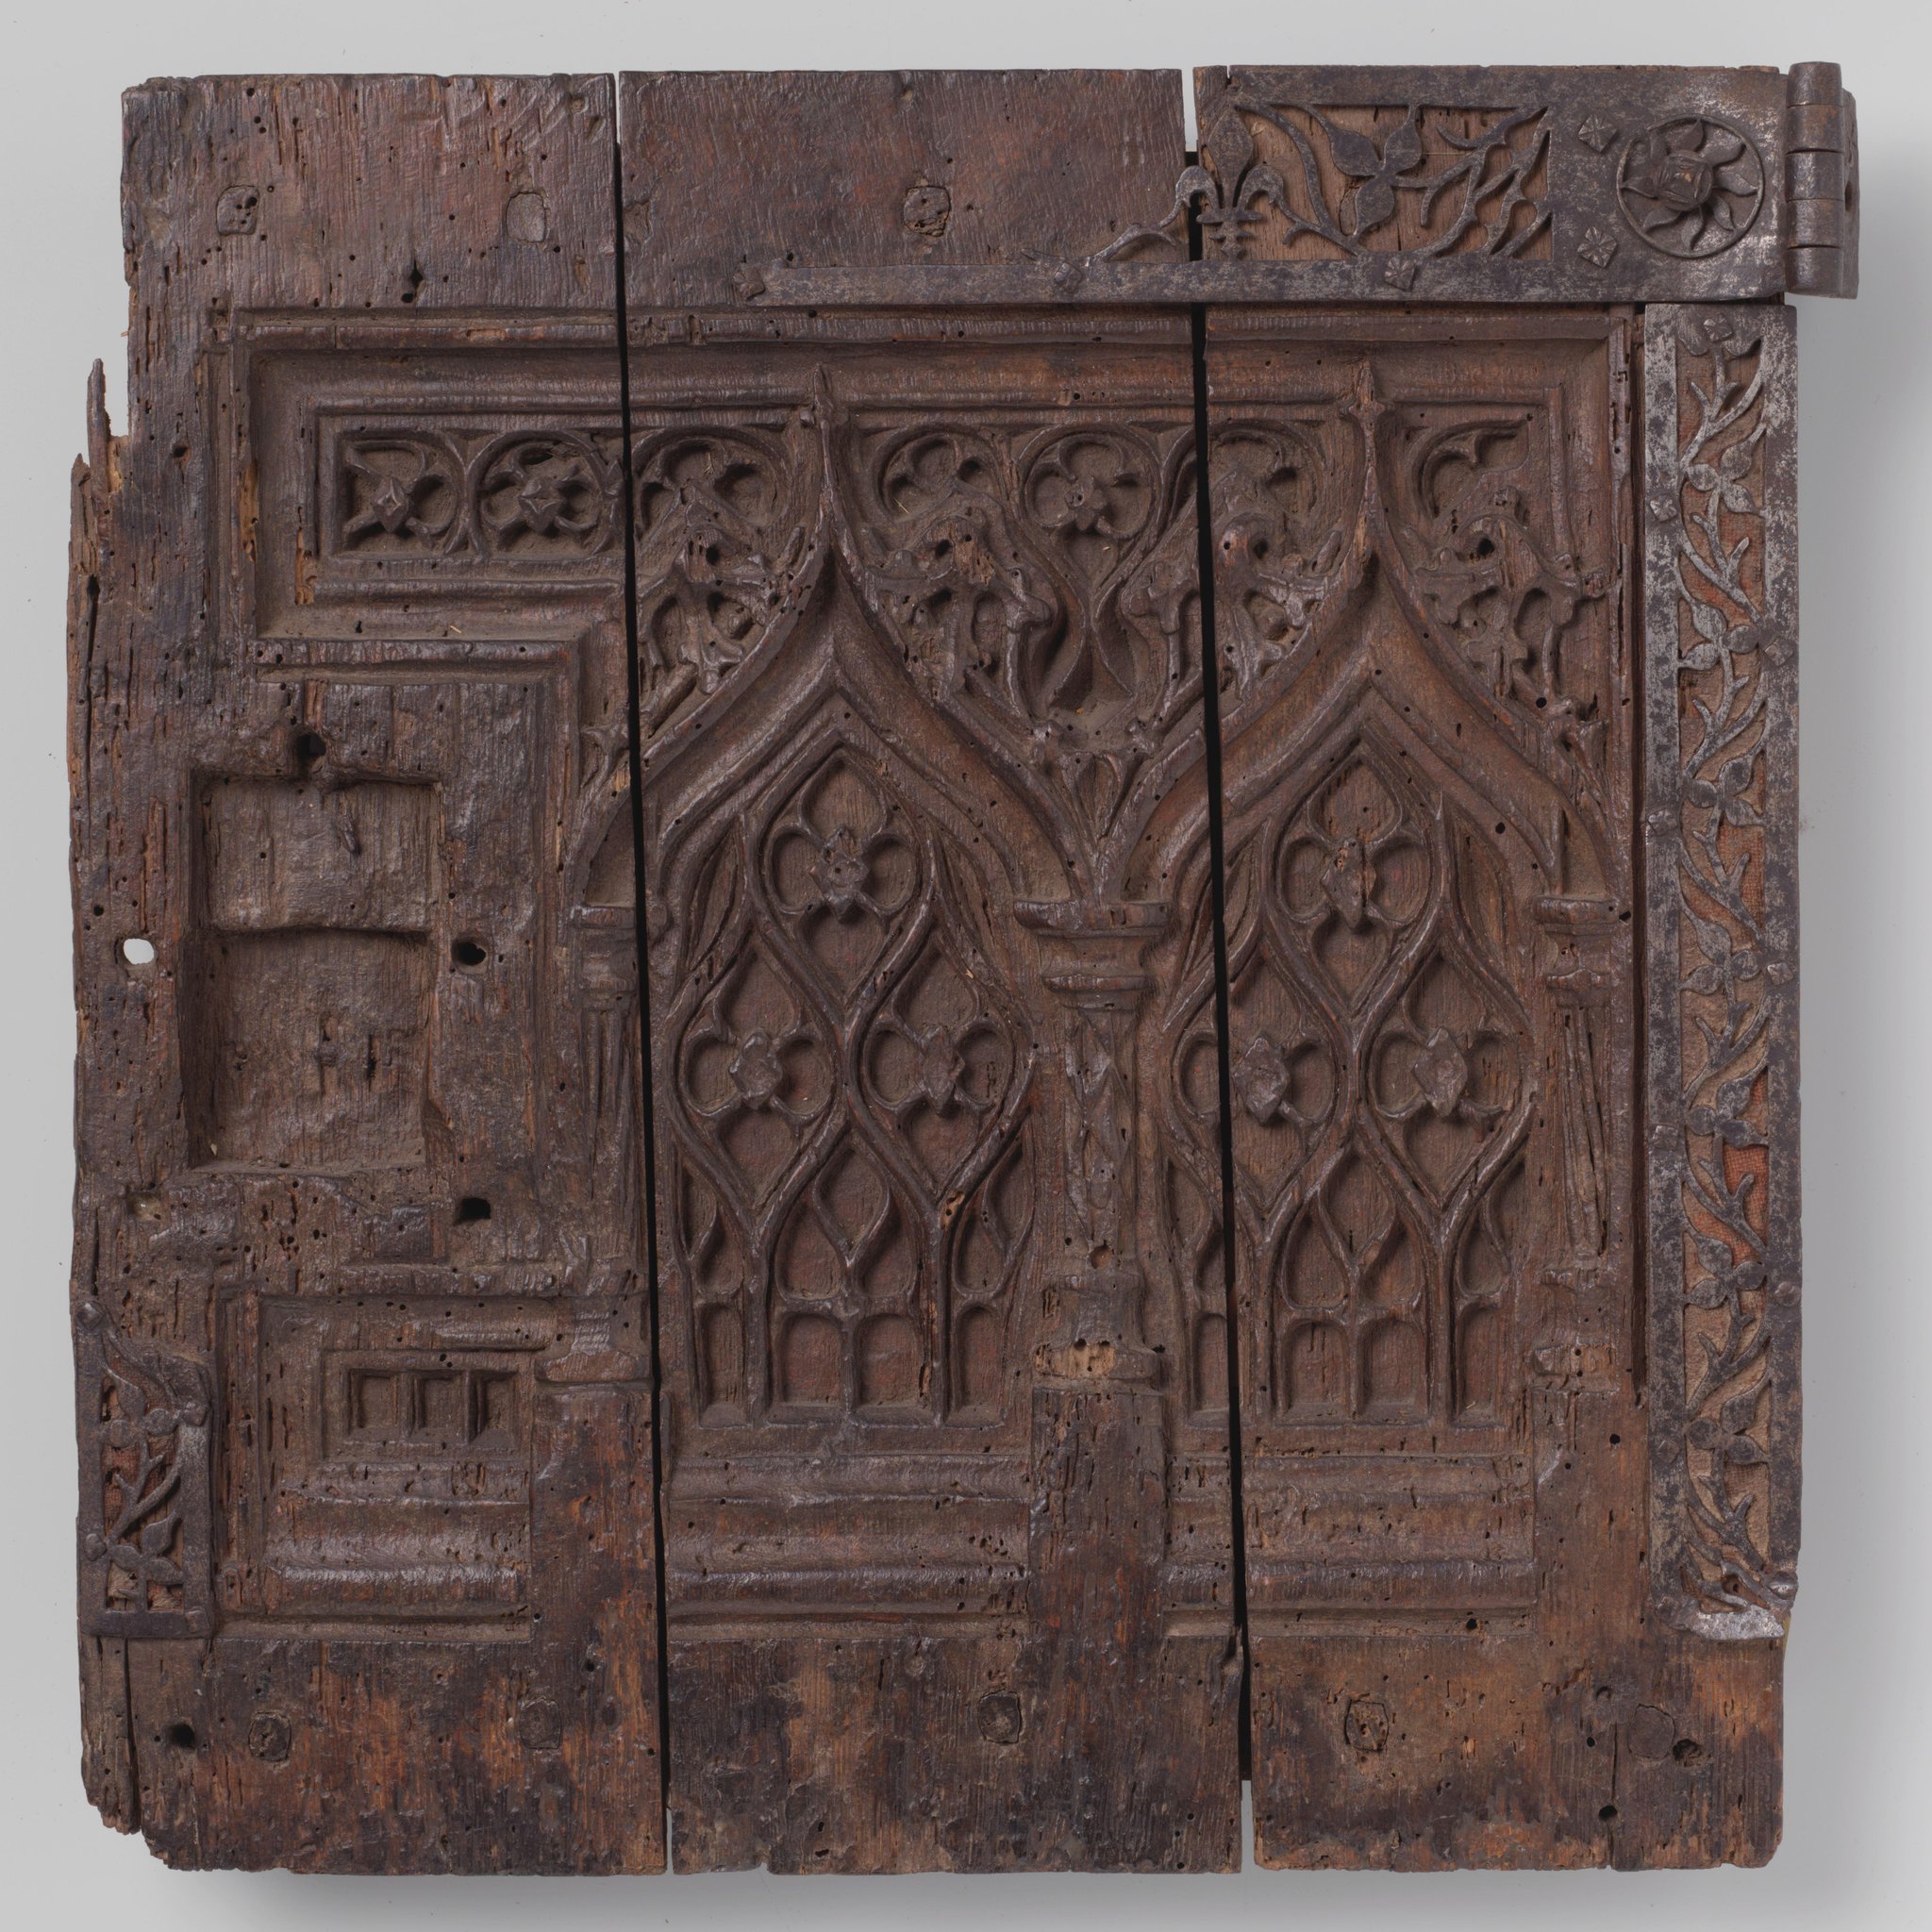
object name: furniture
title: Deur van eikenhout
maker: Anonymous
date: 1500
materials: iron, wood, textile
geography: northern france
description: Deur van eikenhout (van een kast ?), uit drie breedten. De ruimte voor de slotplaat en het inlaat-slot is uitgespaard, het overgebleven uitgegronde middenveld is versierd met blinde traceringen en twee ezelrugbogen op kolommen met beurtelings geruite en getorste schacht. Het beslag bestaat uit platte banden, die het middenveld omlijsten. Zij zijn versierd met opengewerkte ranken van Gotisch "drieblad". In de bovenste rand wisselen drieblad en heraldische lelie elkaar af. Beslag op oude grondlaag van stof.